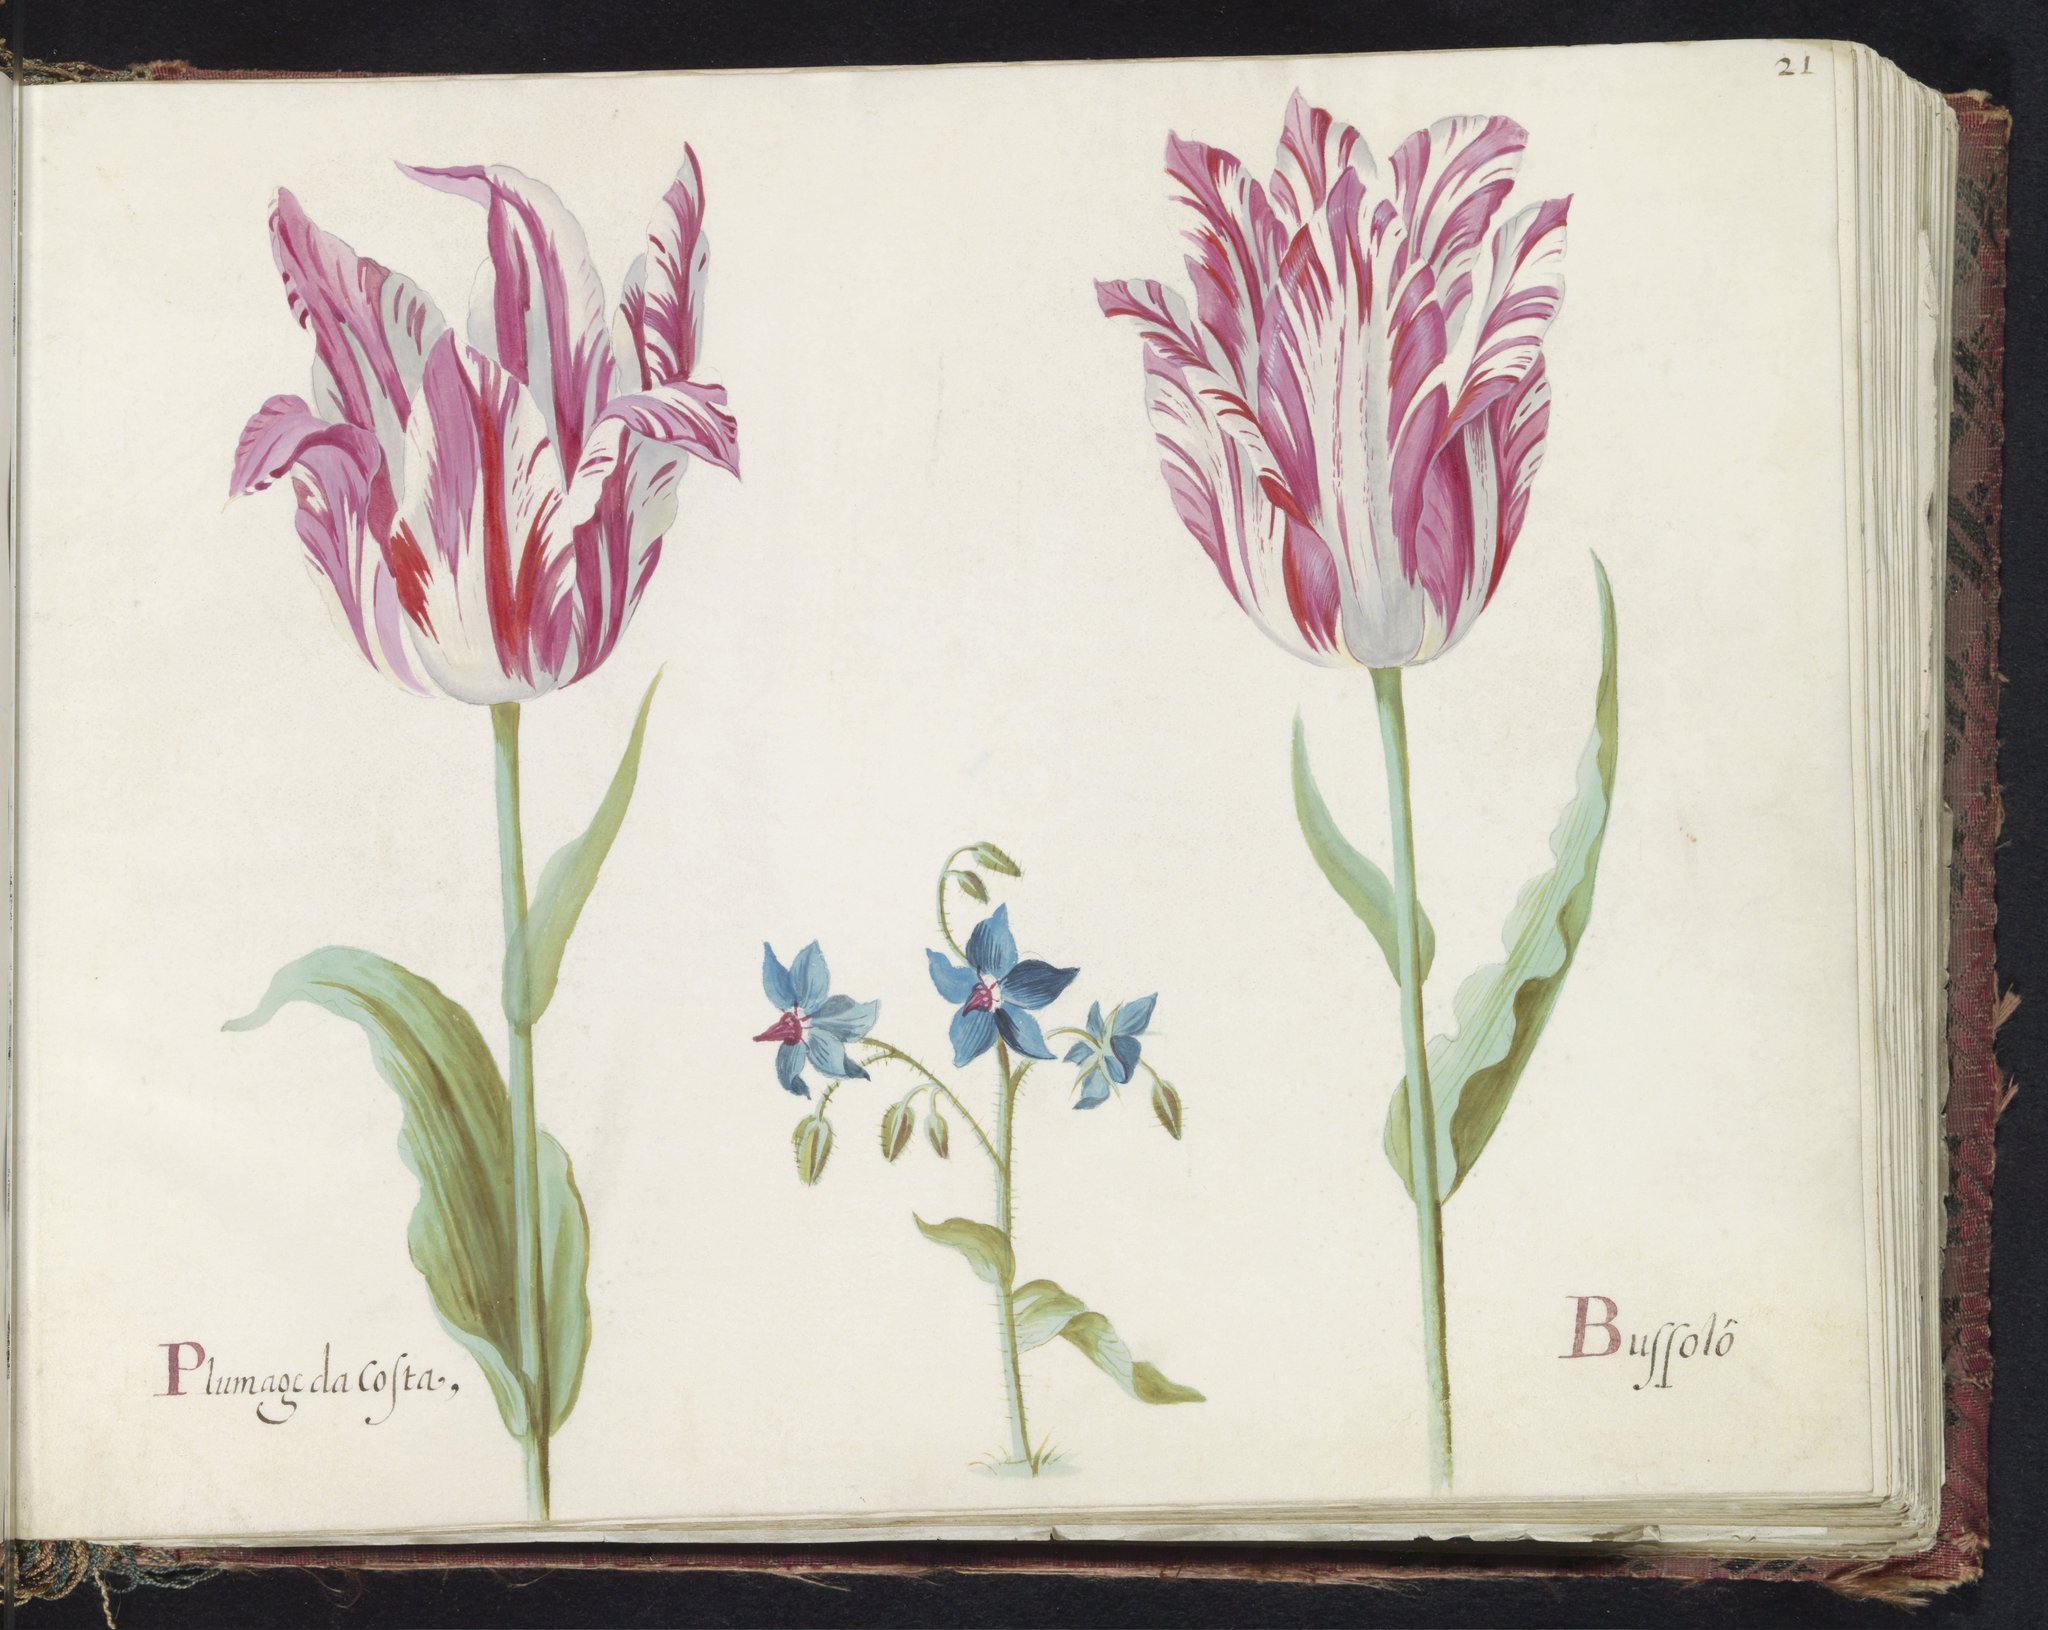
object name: drawing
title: Twee tulpen met onbekende bloeiende plant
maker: jacob marrel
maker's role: draughtsman, painter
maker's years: 1614-1681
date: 1637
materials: paint, parchment, pencil, watercolor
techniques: brush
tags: flowers: tulip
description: De tekening maakt deel uit van een album.